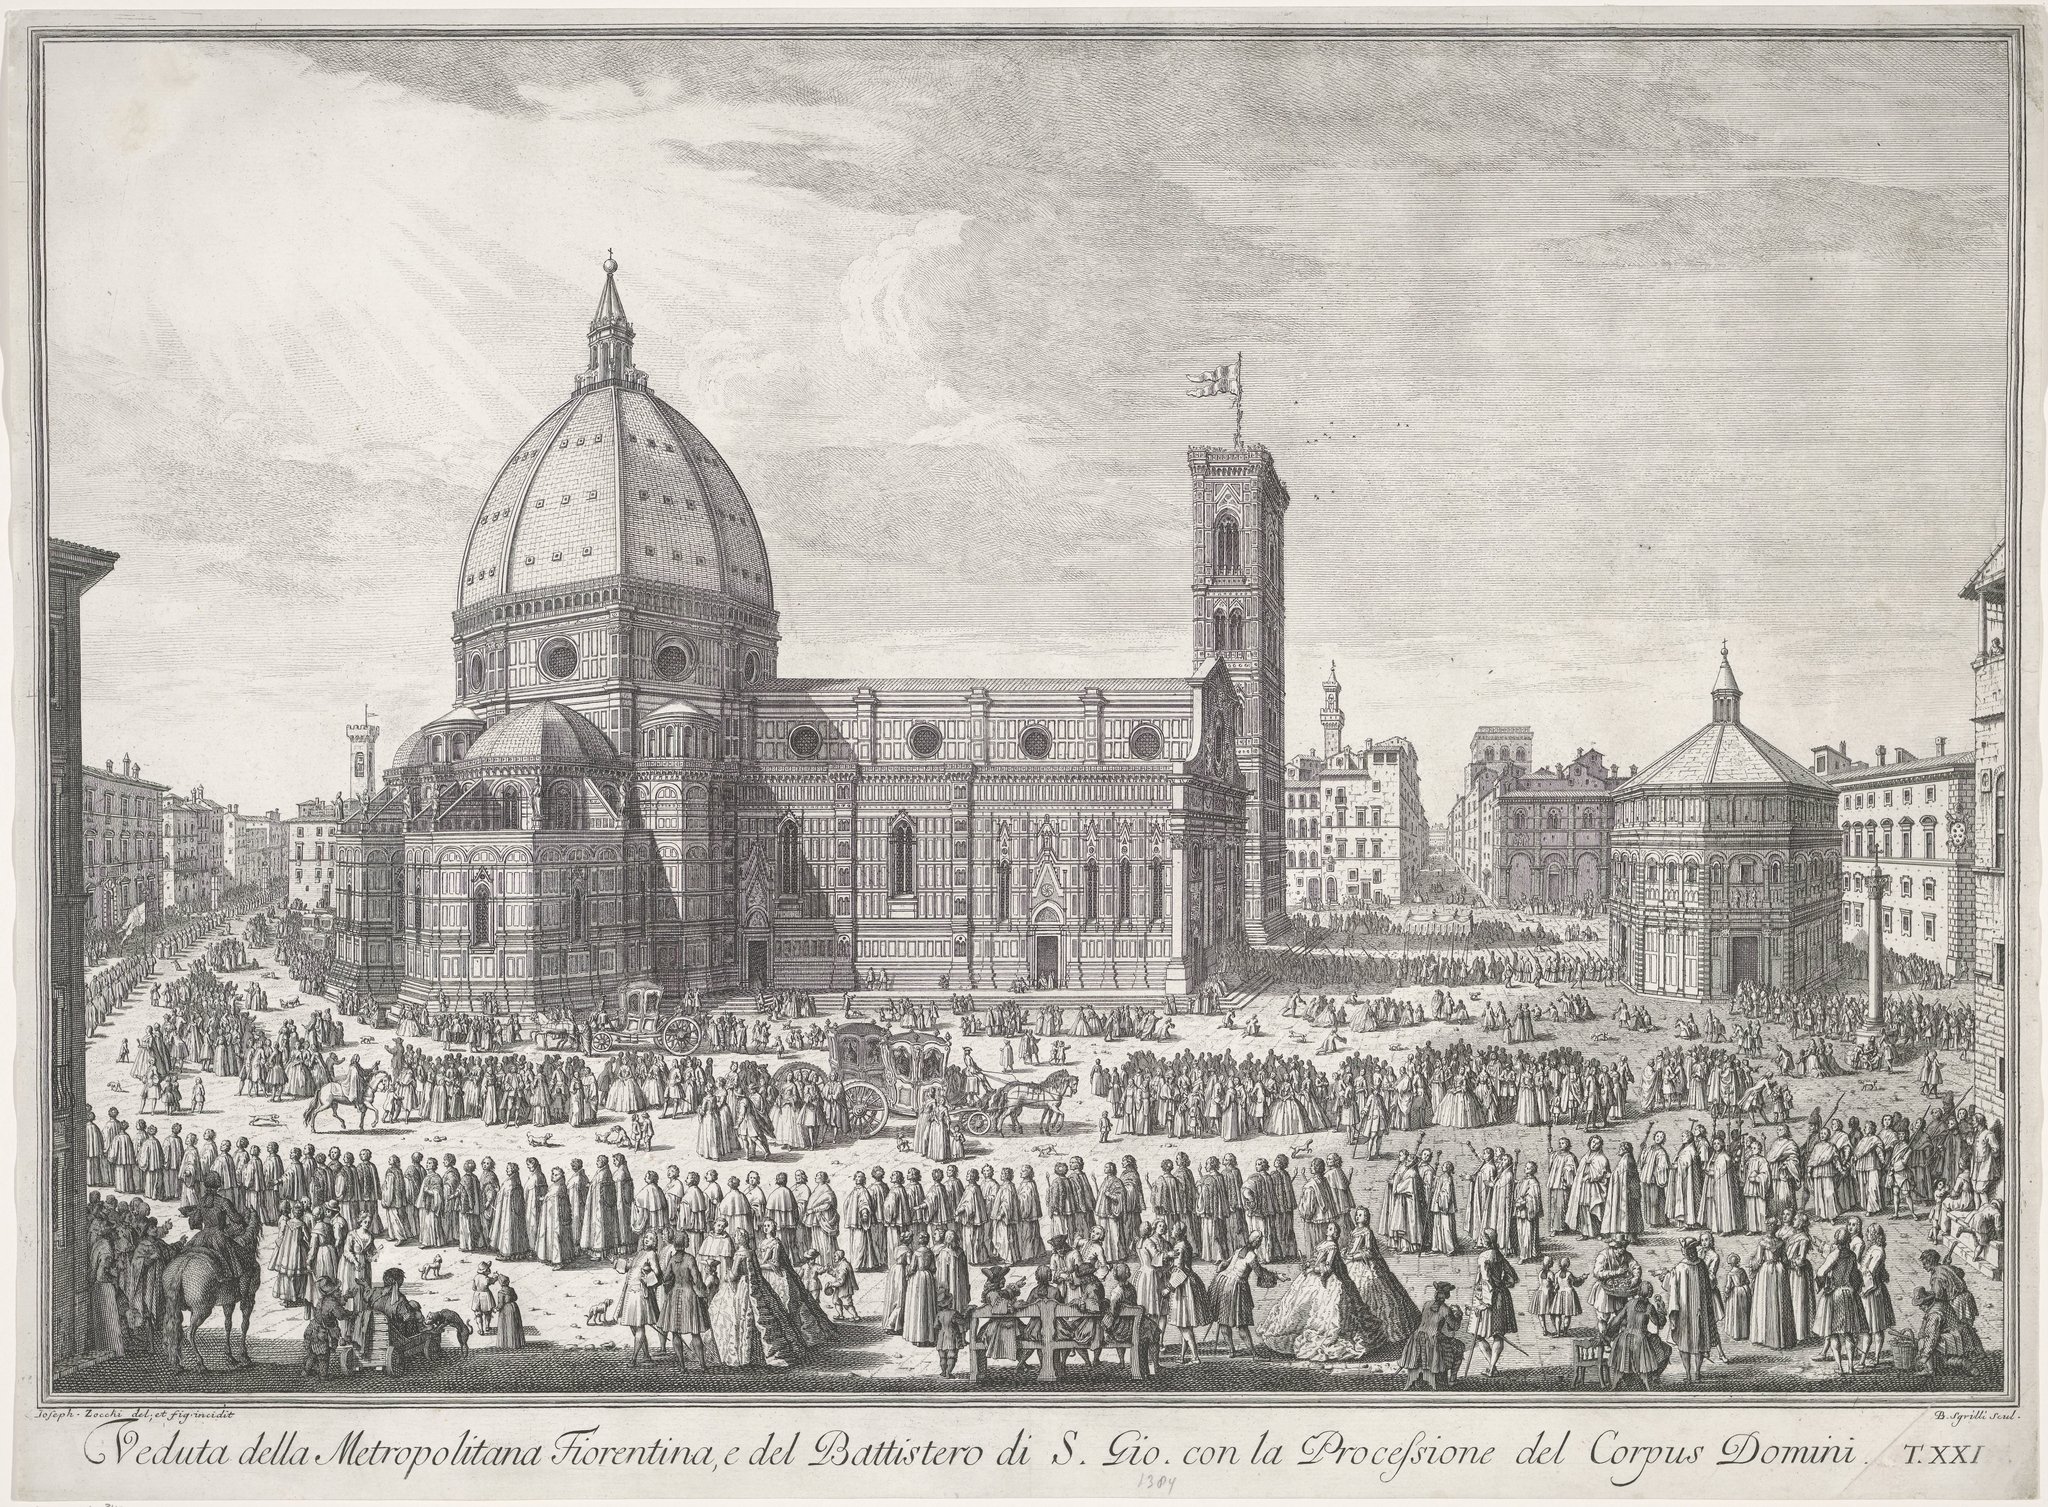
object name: print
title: Processie voor de Santa Maria del Fiore en het Battistero di San Giovanni te Florence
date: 1733-1755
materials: paper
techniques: etching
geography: italy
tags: church (exterior), procession ~ christian religion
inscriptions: collector's mark: Lugt 2228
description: Een religieuze processie voor de Santa Maria del Fiore en het Battistero di San Giovanni te Florence.